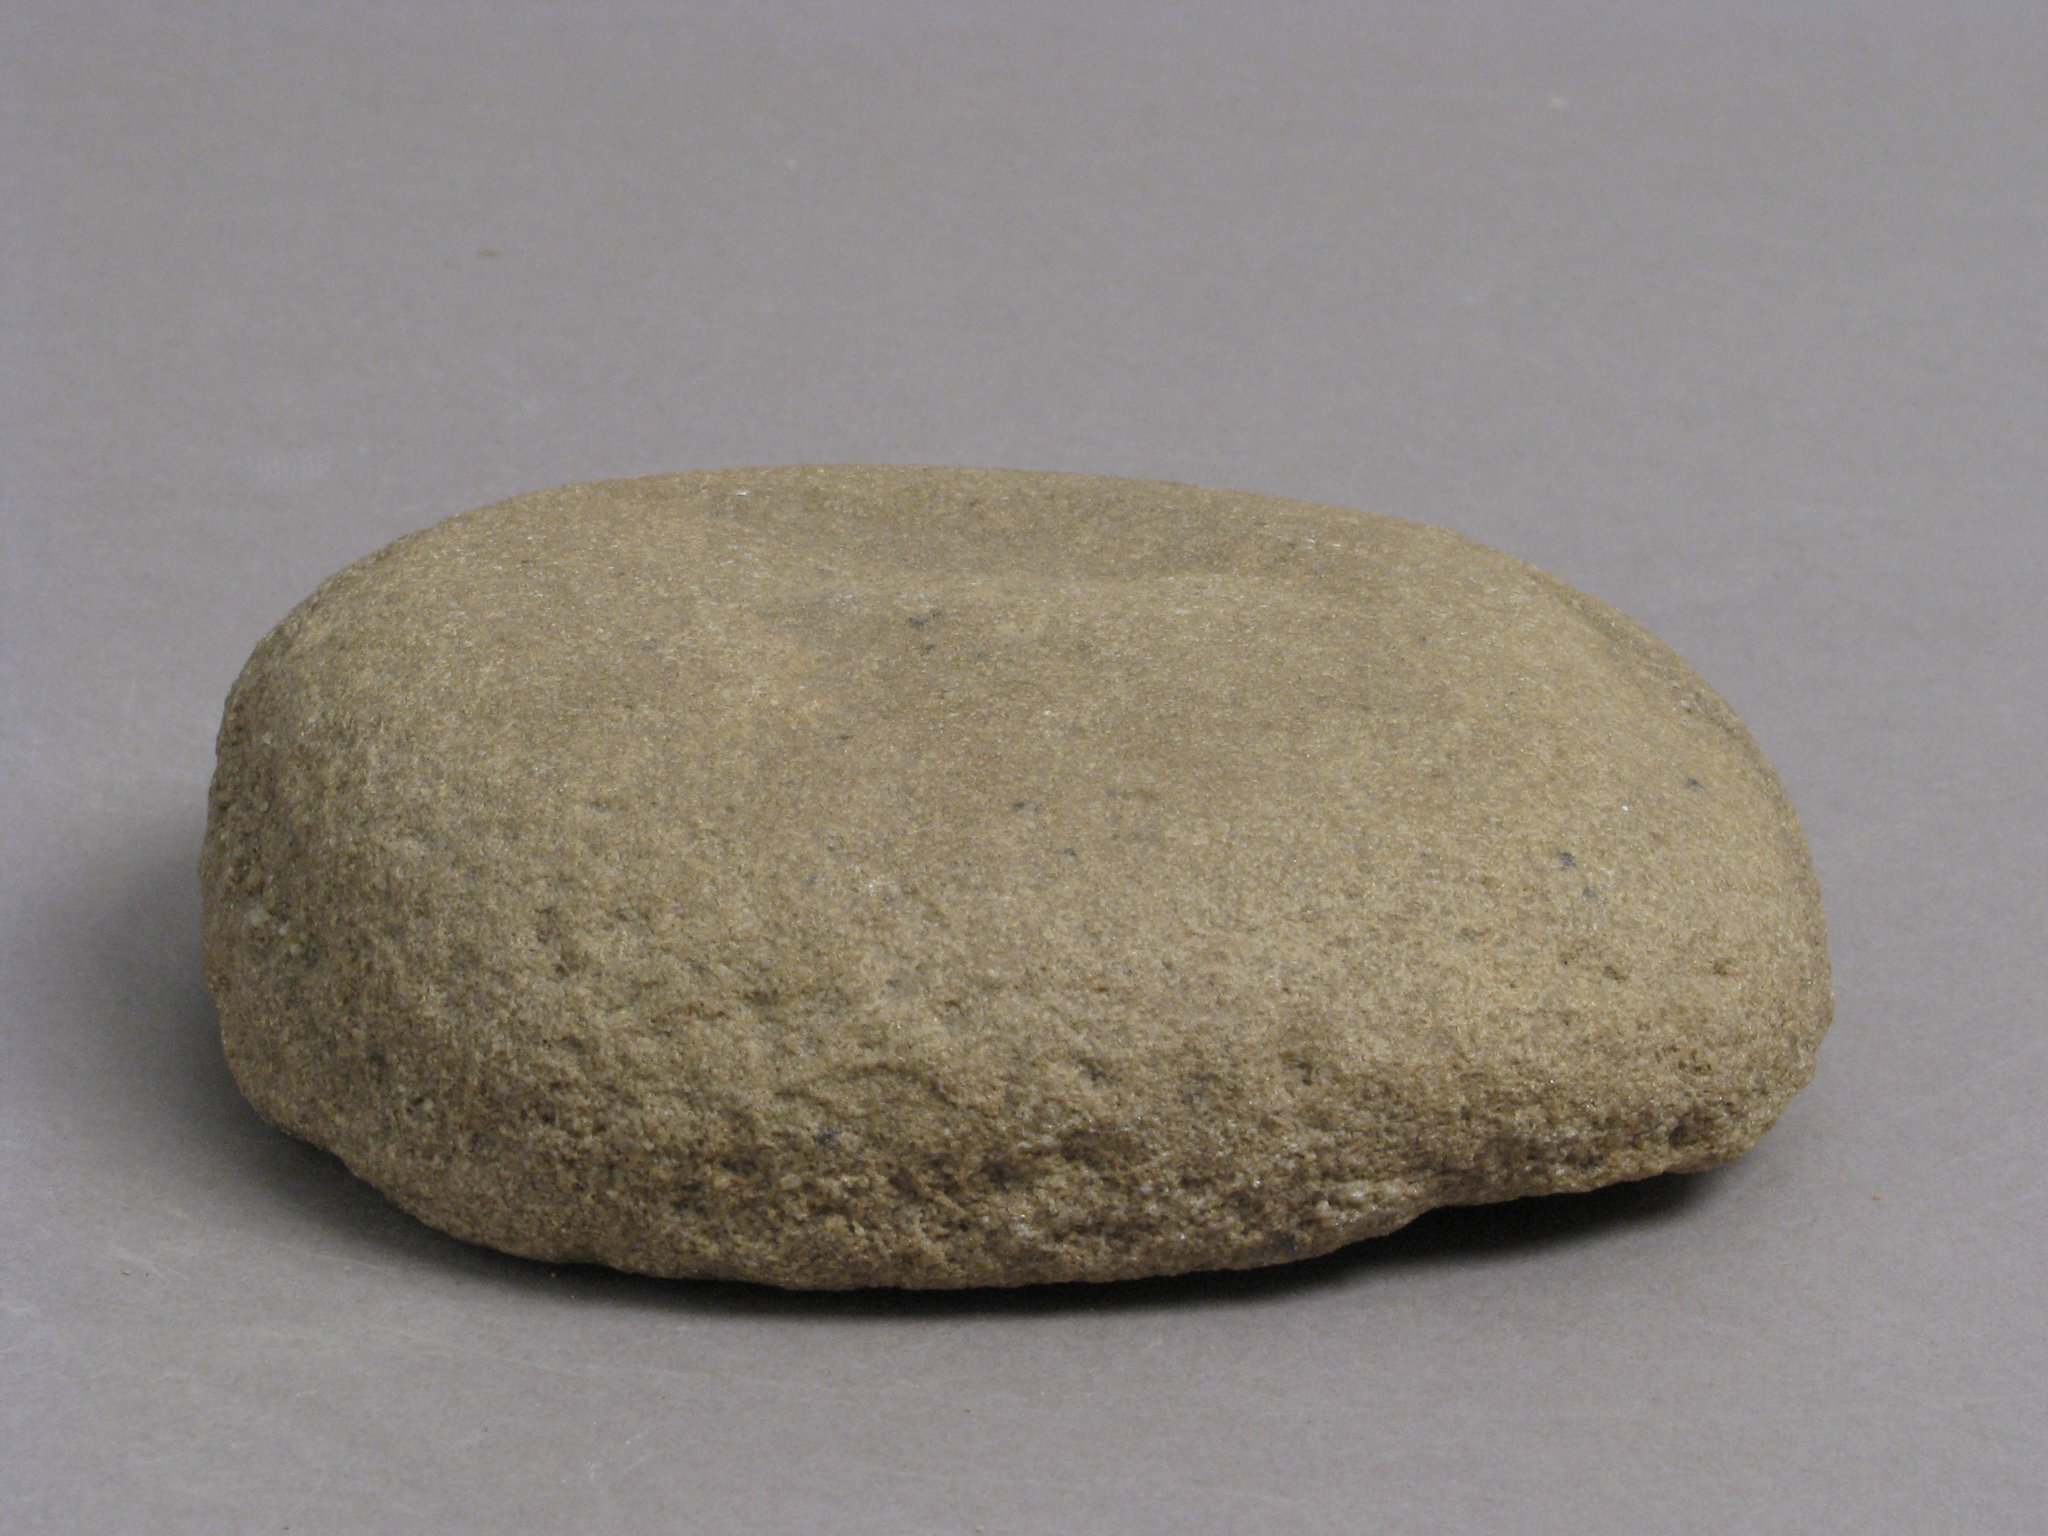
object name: stone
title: Grinding Stone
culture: coptic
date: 301-700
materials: stone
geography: egypt